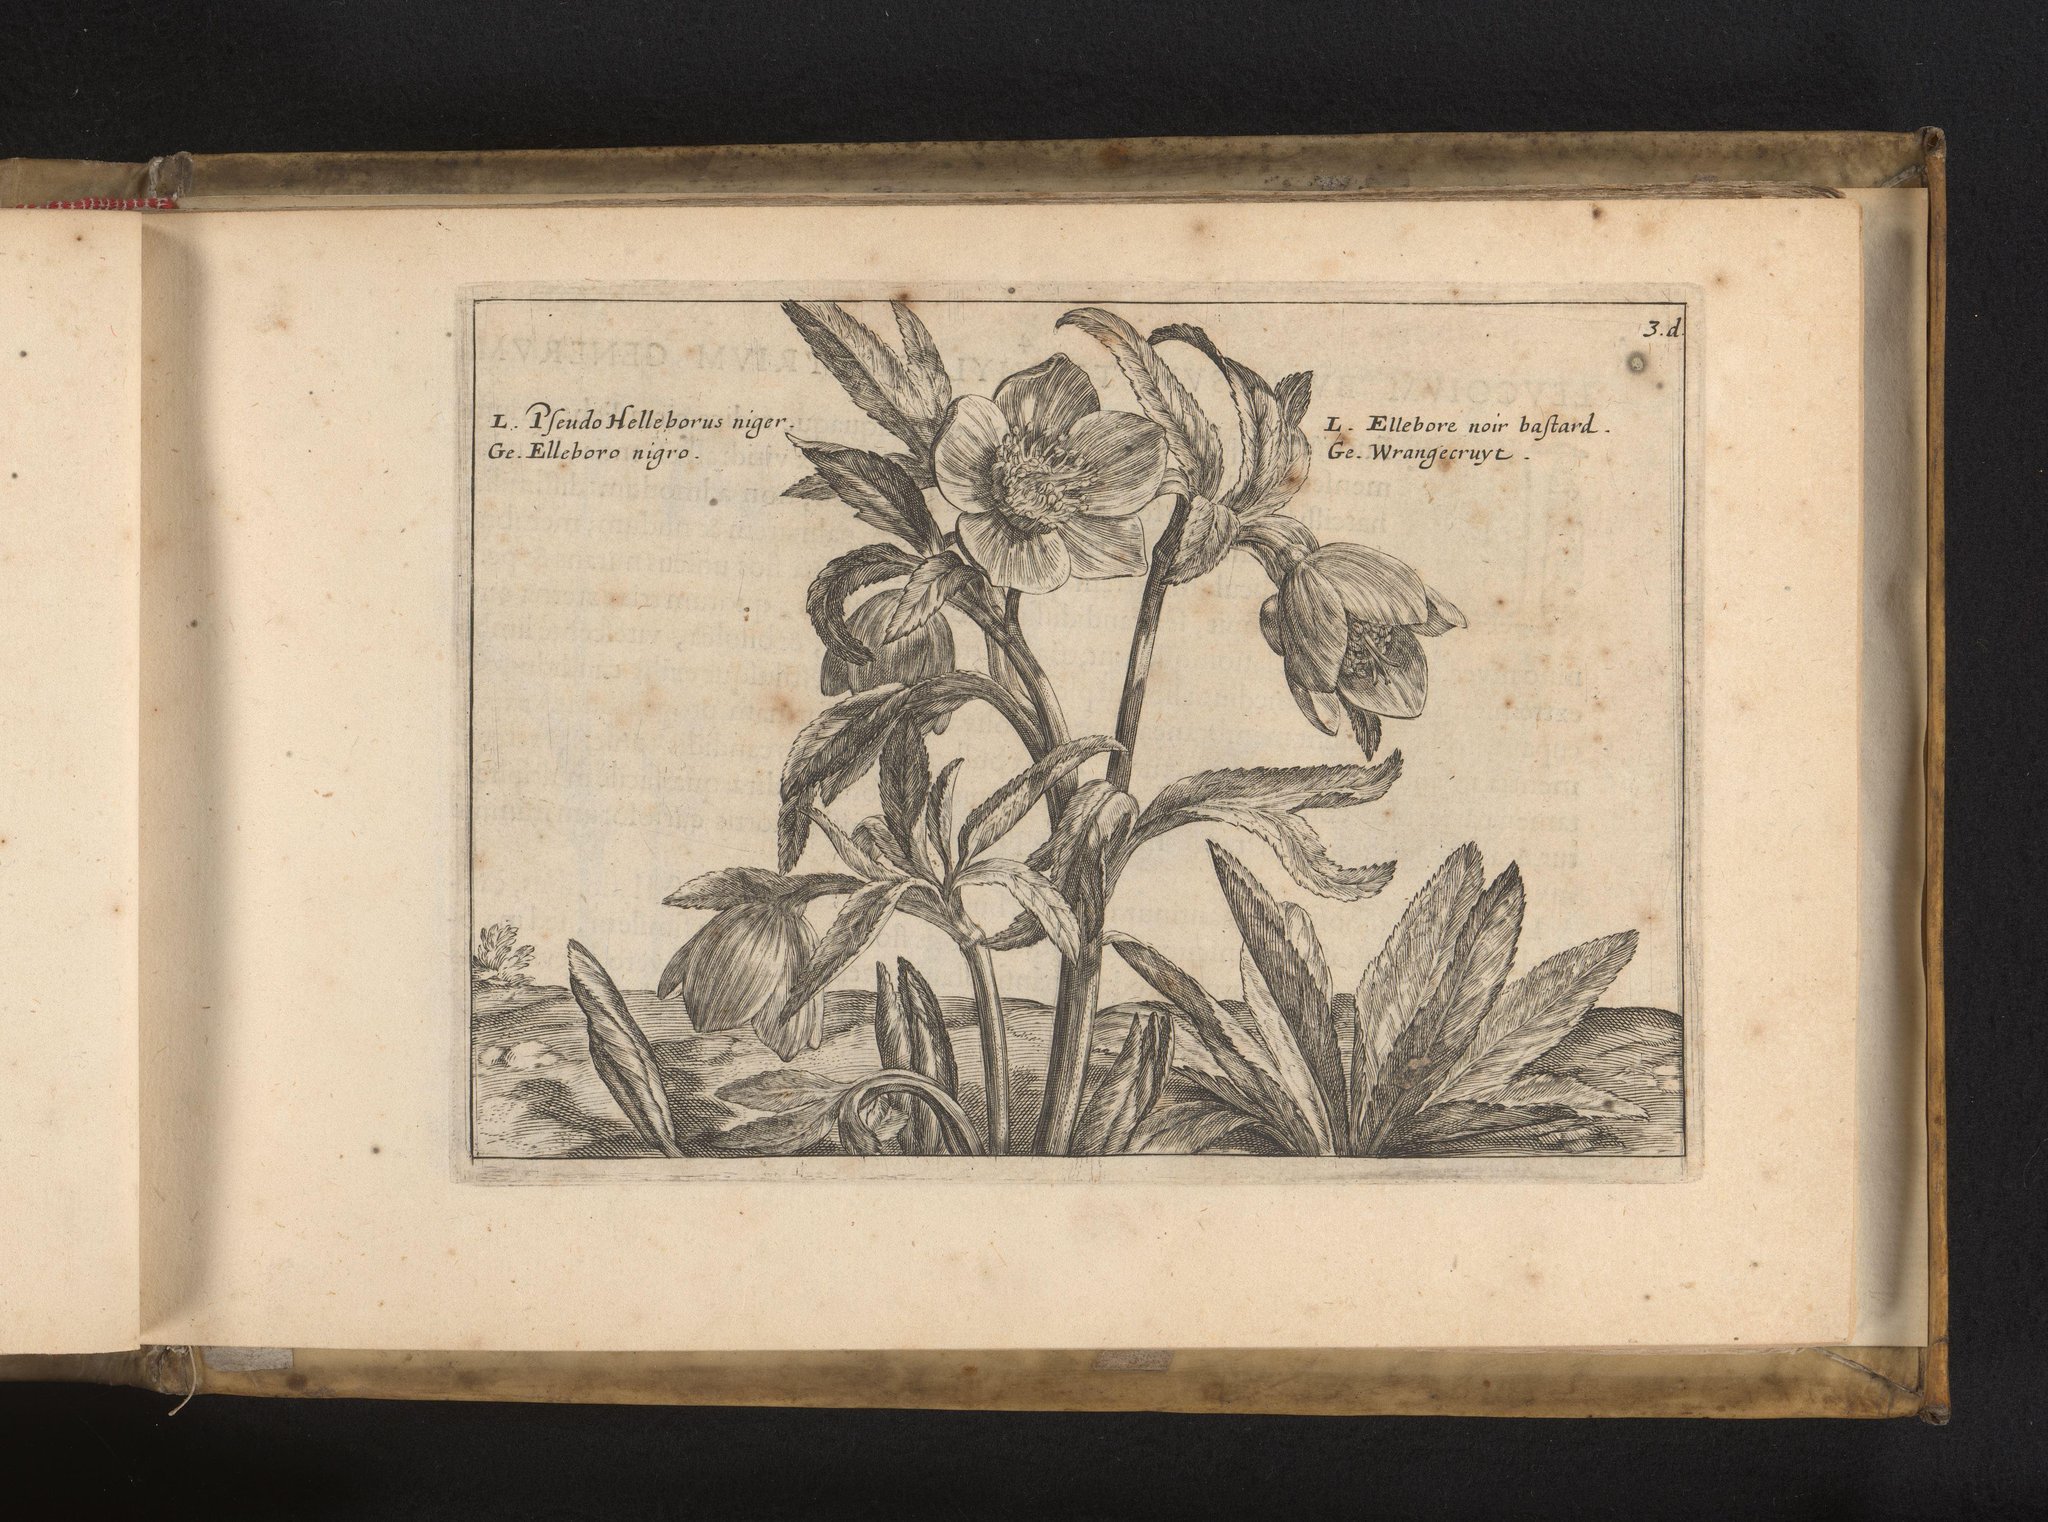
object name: book illustration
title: Pseudo Helleborus niger / Elleboro nigro / Ellebore noir bastard / Wrangecruyt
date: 1617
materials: paper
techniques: engraving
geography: utrecht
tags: flowers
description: Prent uit: Passe, Crispijn van de (II). Hortus floridus in quo rariorum & minus vulgarium florum icones ad vivam veramque formam. Arnhem: Johannes Janssonius, 1617.